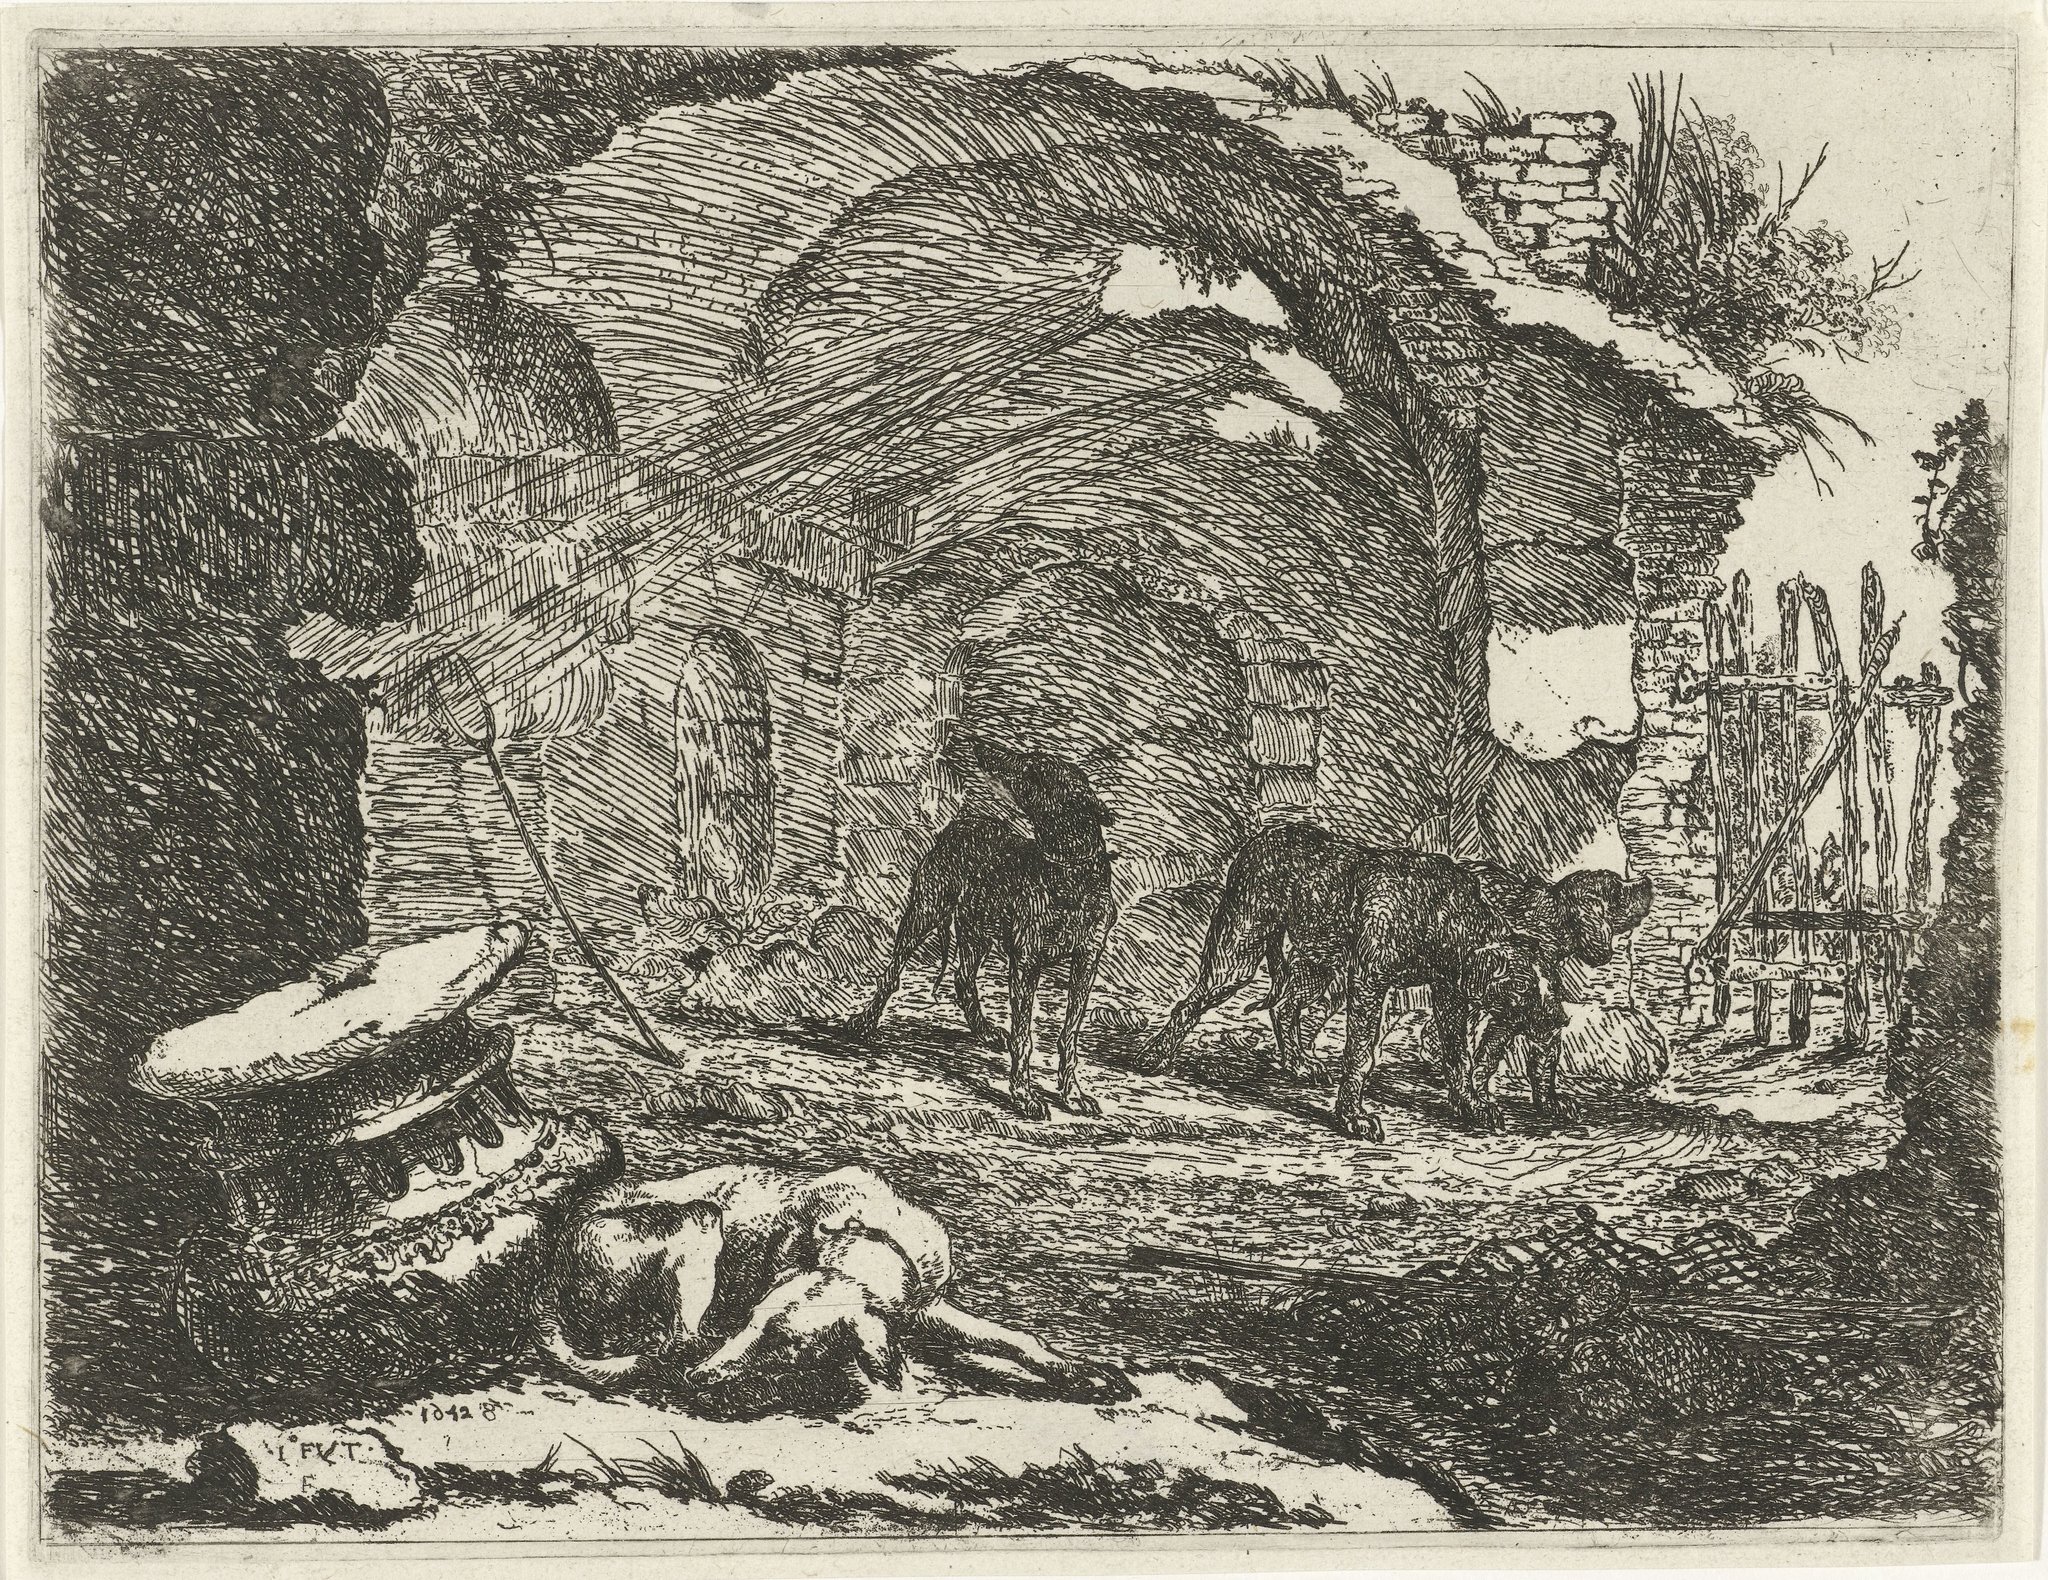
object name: print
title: Honden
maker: joannes fijt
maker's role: draughtsman, print maker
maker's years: 1611-1661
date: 1642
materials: paper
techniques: etching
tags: ruin of a dwelling, house, castle, etc., dog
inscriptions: collector's mark: Lugt 2228